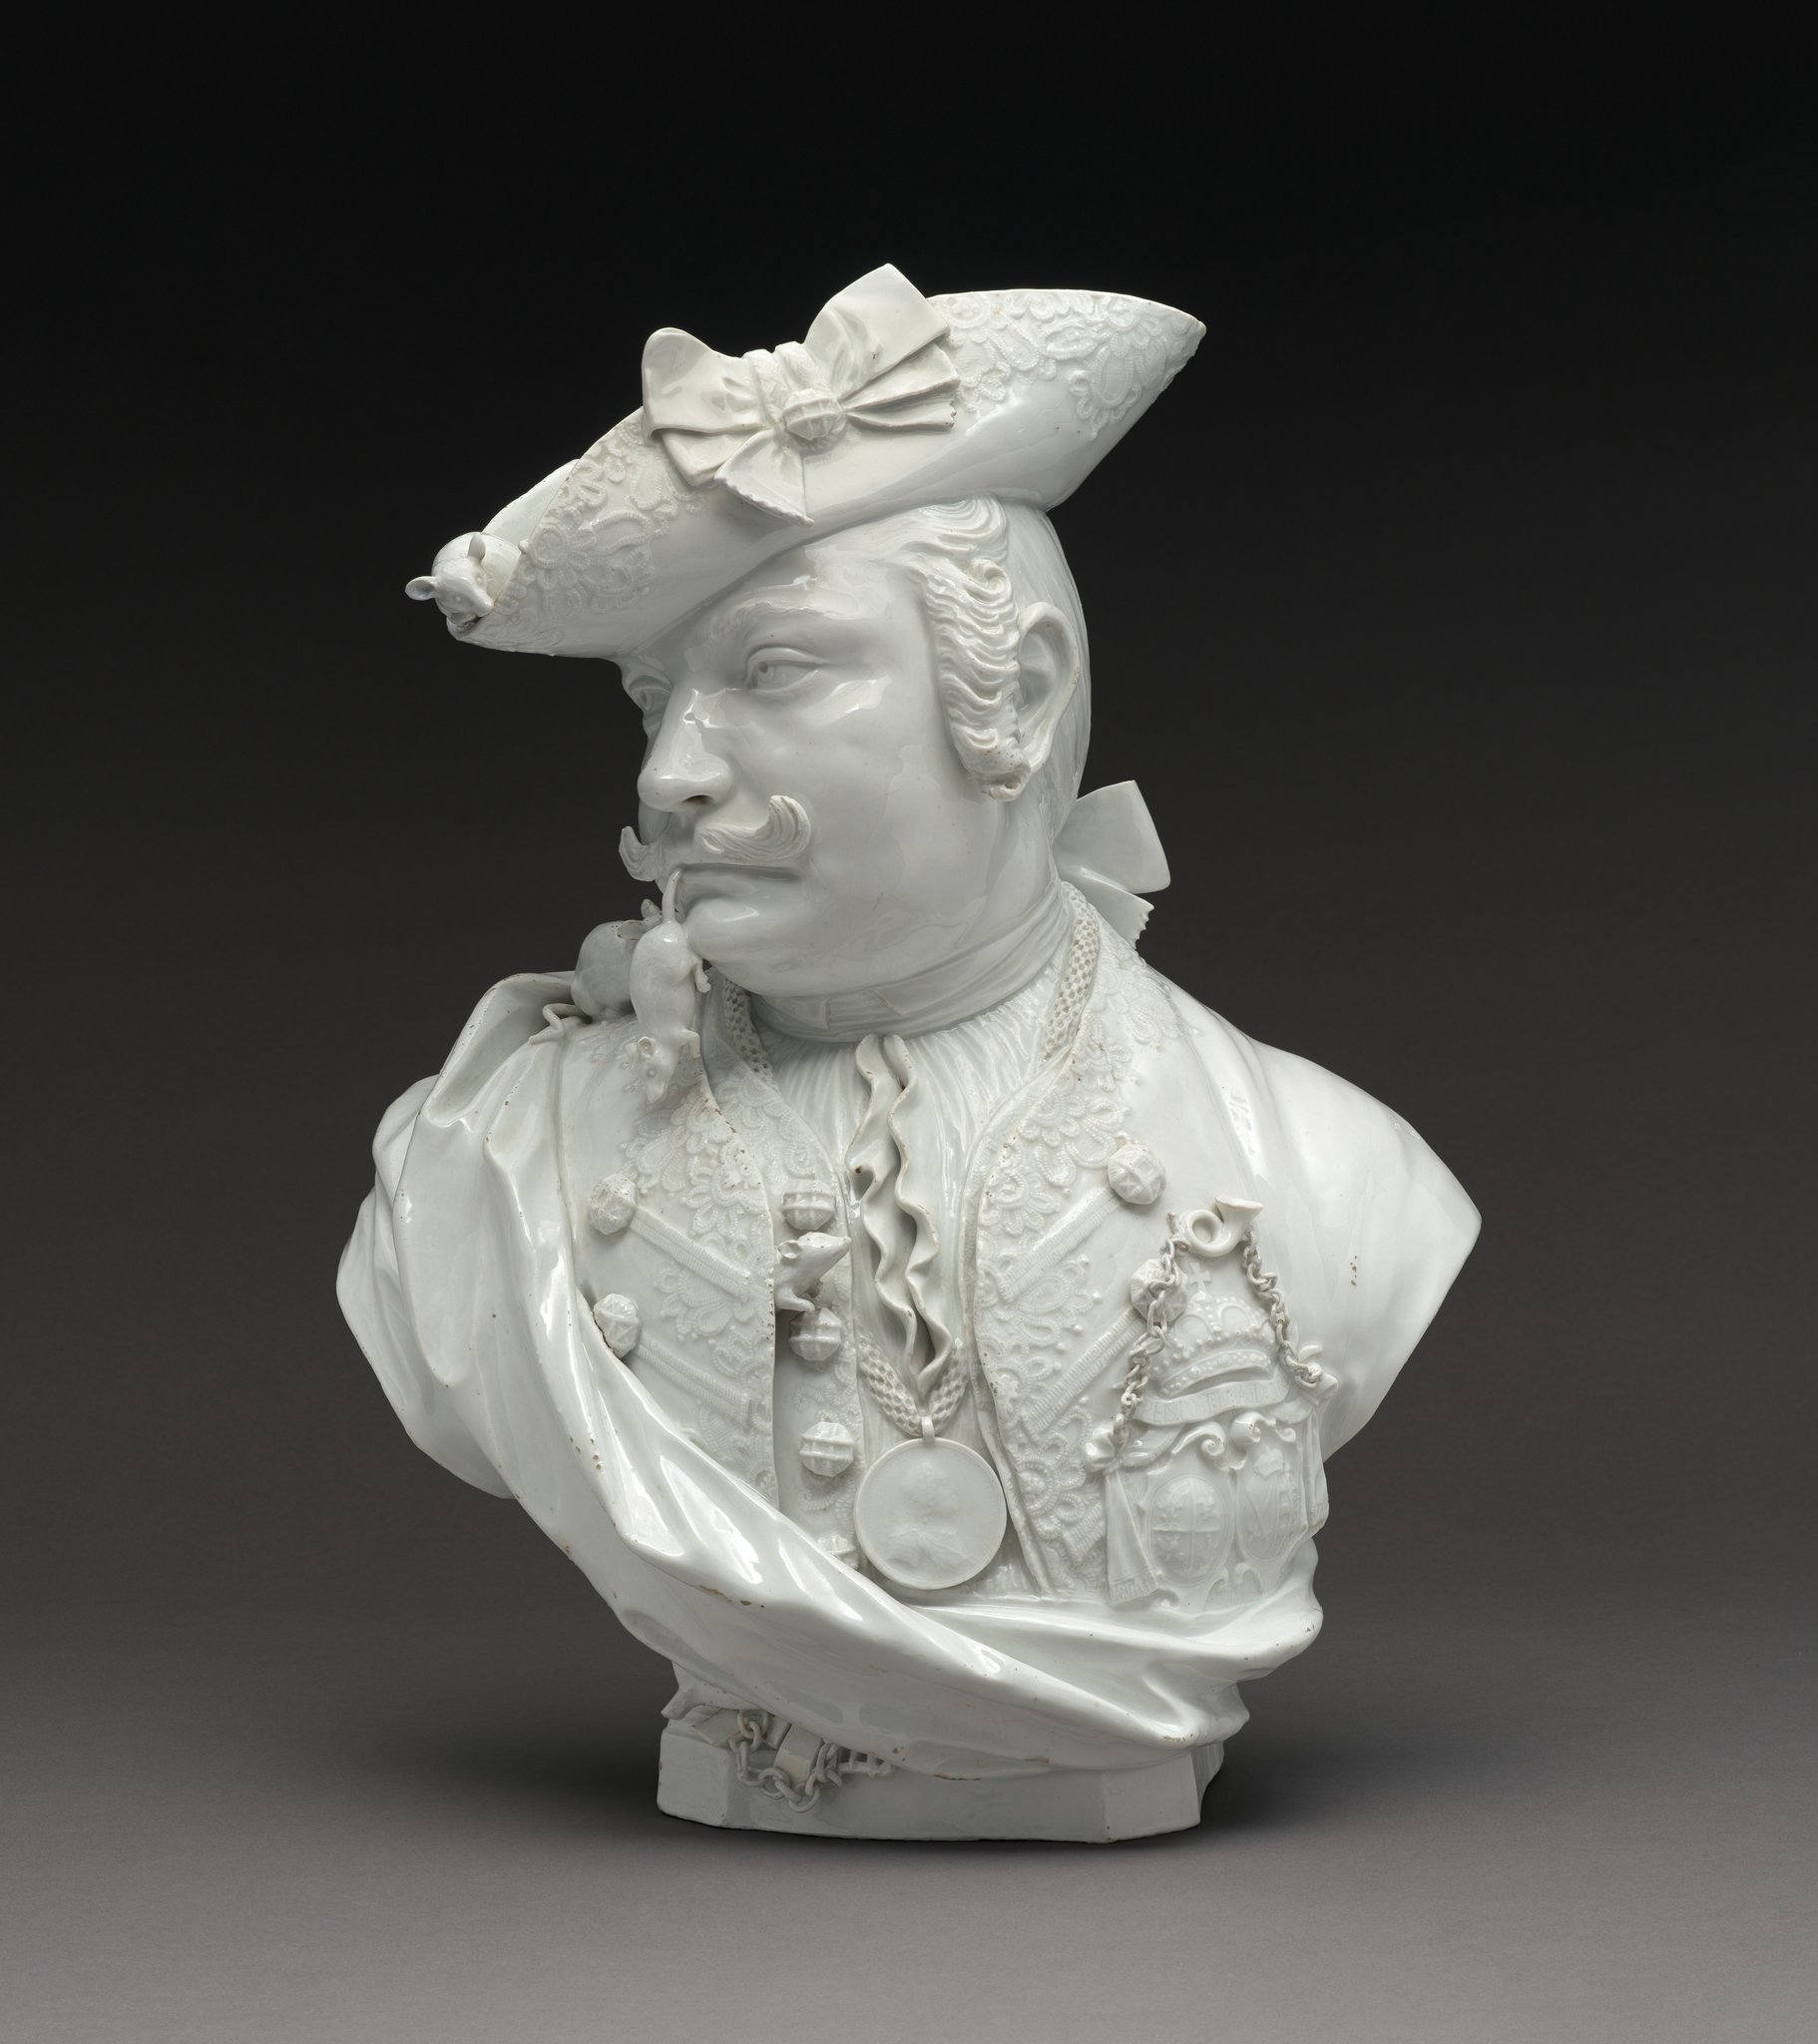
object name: bust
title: Bust of "Baron" Schmiedel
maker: meissen manufactory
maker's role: manufactory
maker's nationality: german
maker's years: 1710-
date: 1739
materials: hard paste porcelain